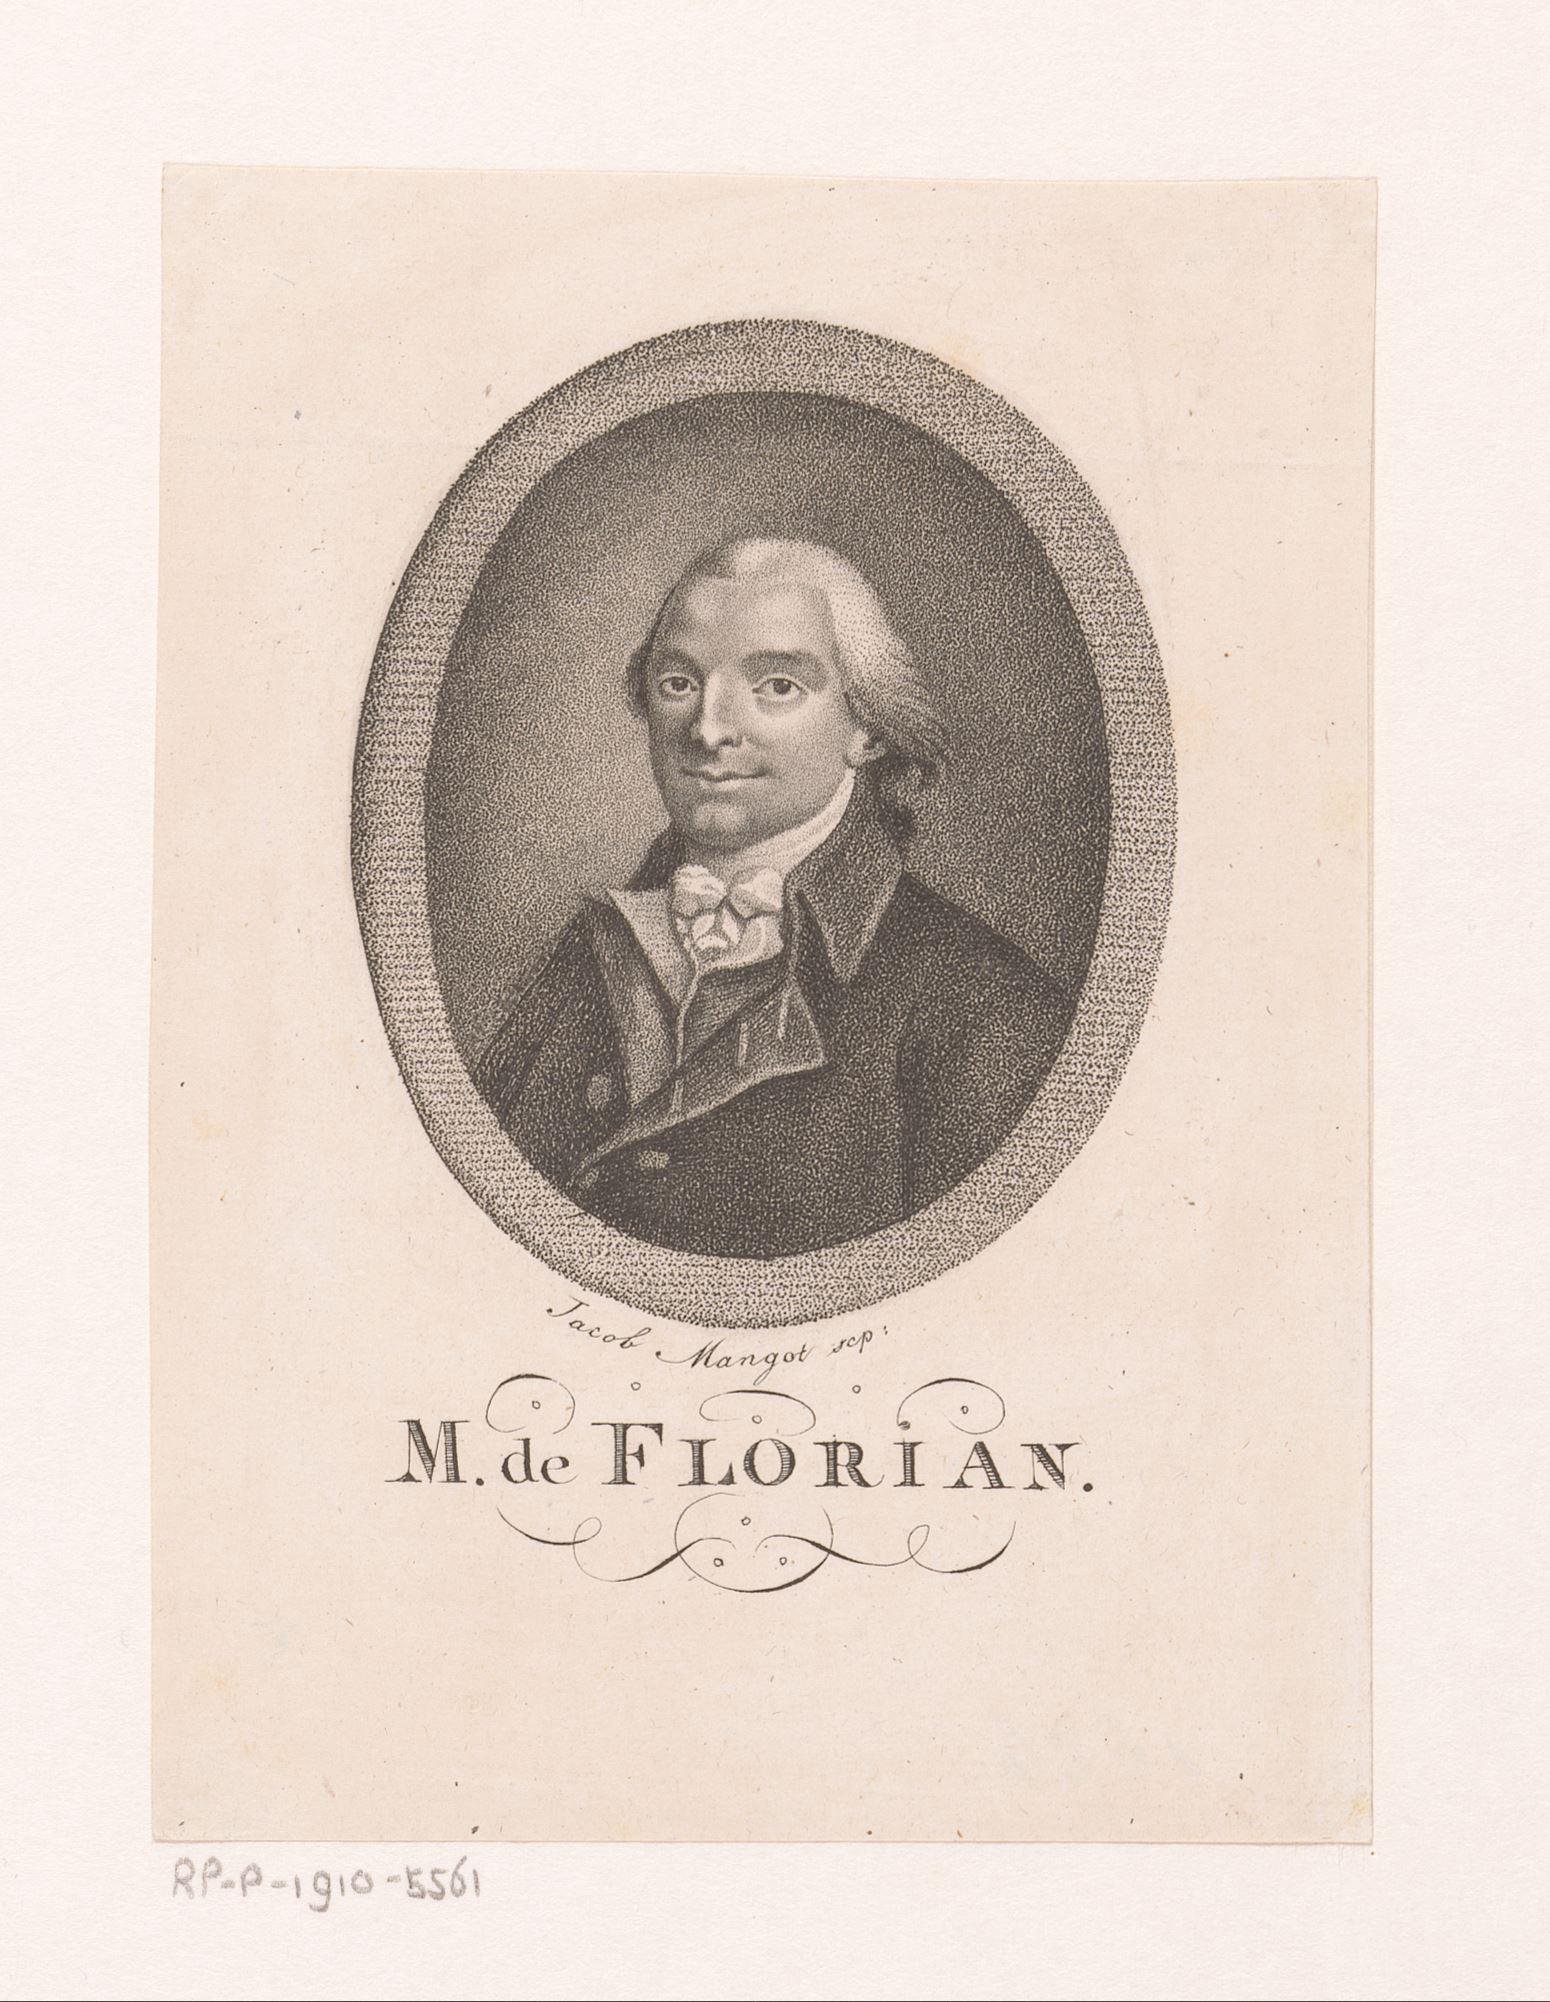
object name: book illustration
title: Portret van Jean-Pierre Claris de Florian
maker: jacob mangot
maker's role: print maker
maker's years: 1701-1800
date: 1810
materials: paper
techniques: stippling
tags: historical persons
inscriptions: collector's mark: Lugt 2228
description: Ook gebruikt als illustratie in: Florian, Jean-Pierre Claris de. Oeuvres complètes. Tome premier. Leipzig: Gerhard Fleischer, 1810.